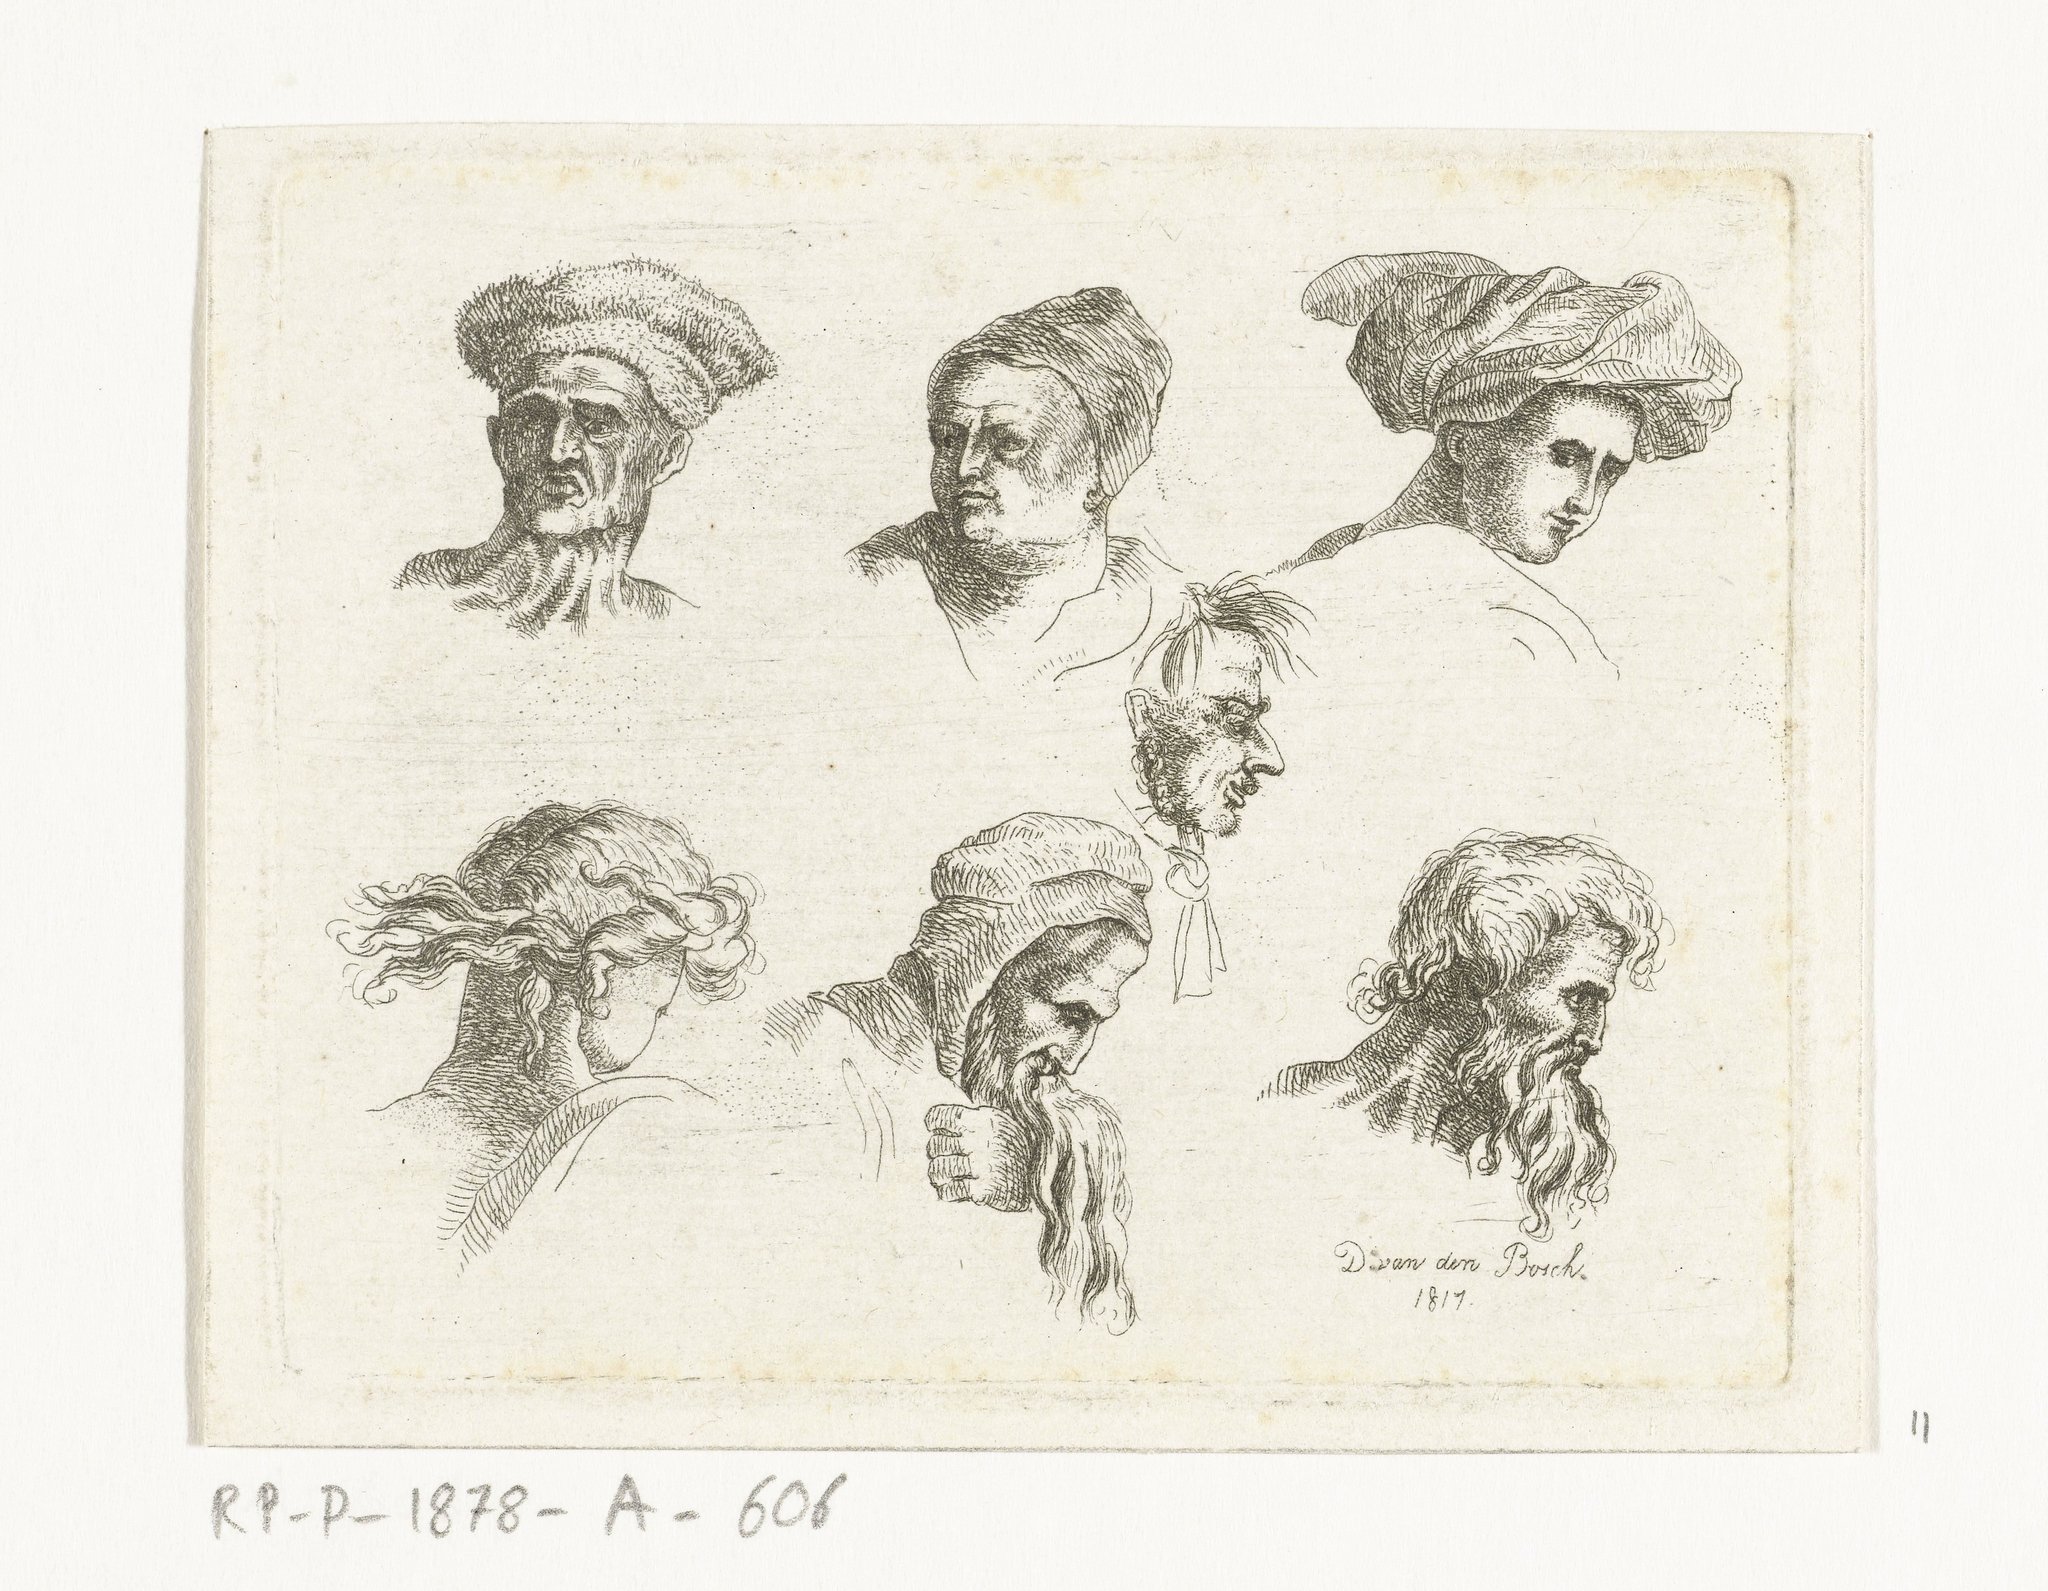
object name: print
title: Studieblad met zes hoofden in twee rijen boven elkaar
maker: d. van den bosch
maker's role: print maker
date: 1817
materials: paper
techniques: etching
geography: netherlands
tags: postures of the head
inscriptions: collector's mark: Lugt 2227